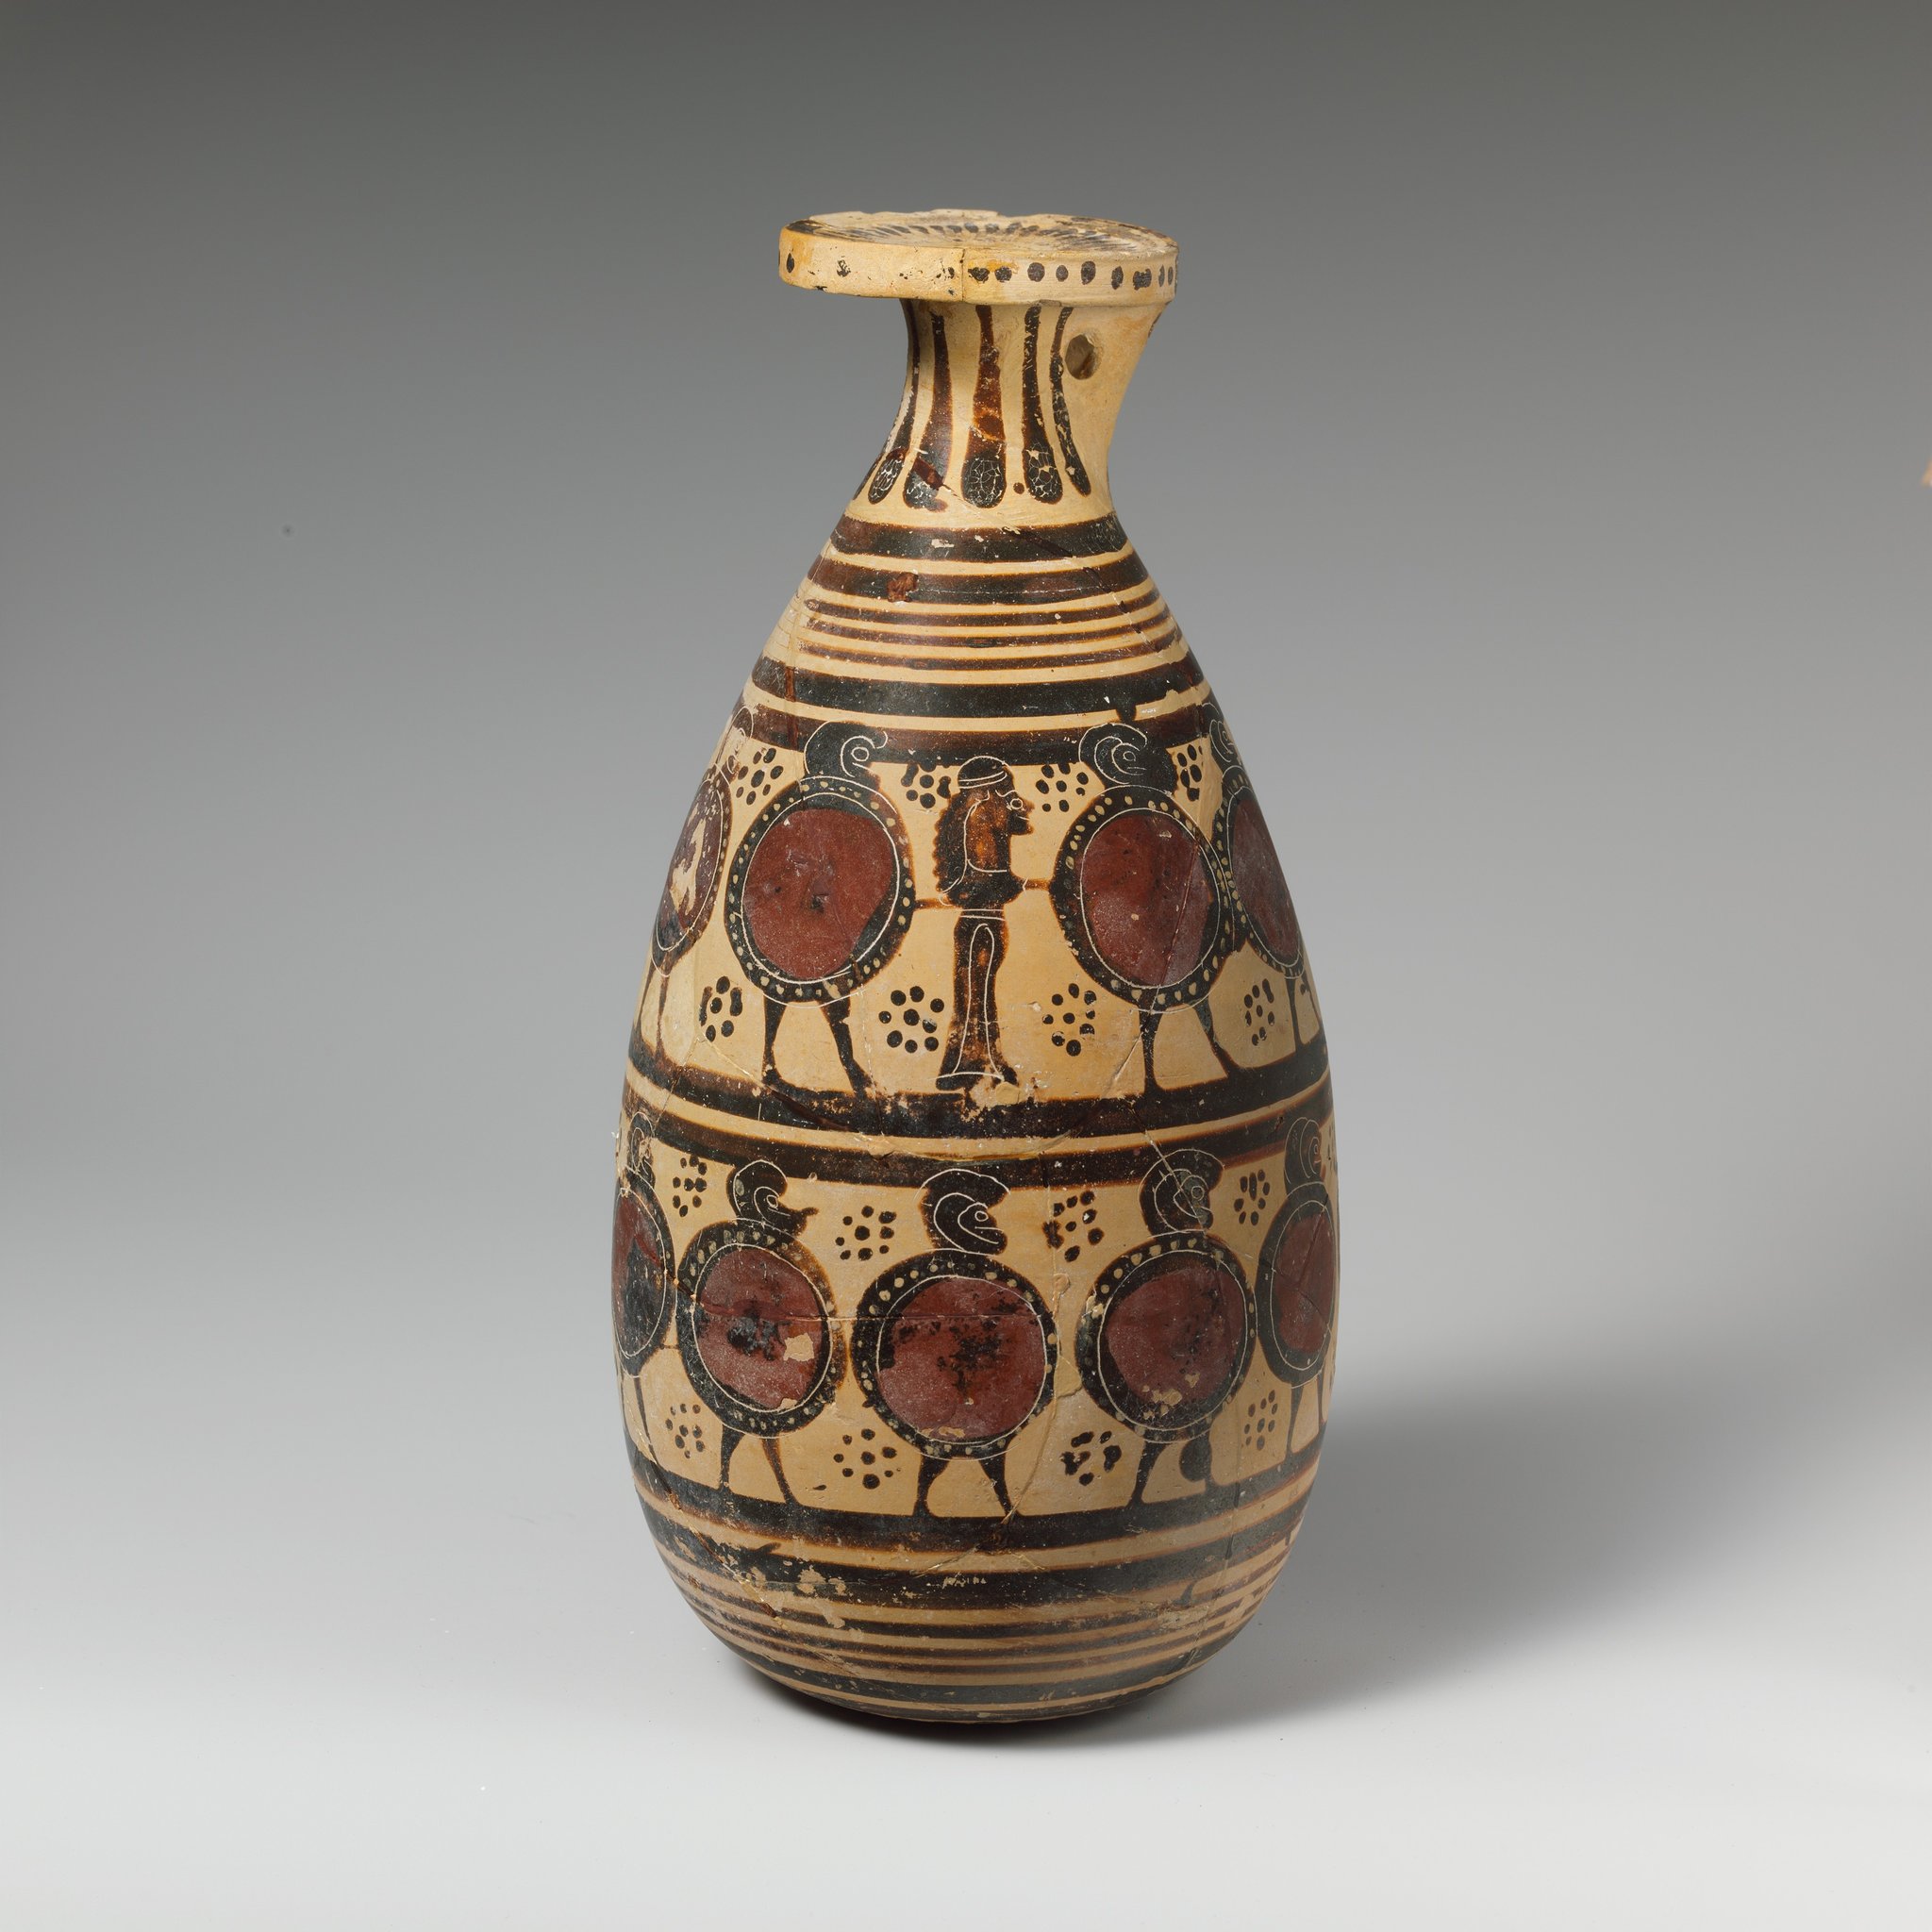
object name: alabastron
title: Terracotta alabastron (perfume vase)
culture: greek, corinthian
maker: late warrior frieze vases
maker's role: artist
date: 590-570 BCE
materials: terracotta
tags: shields,men